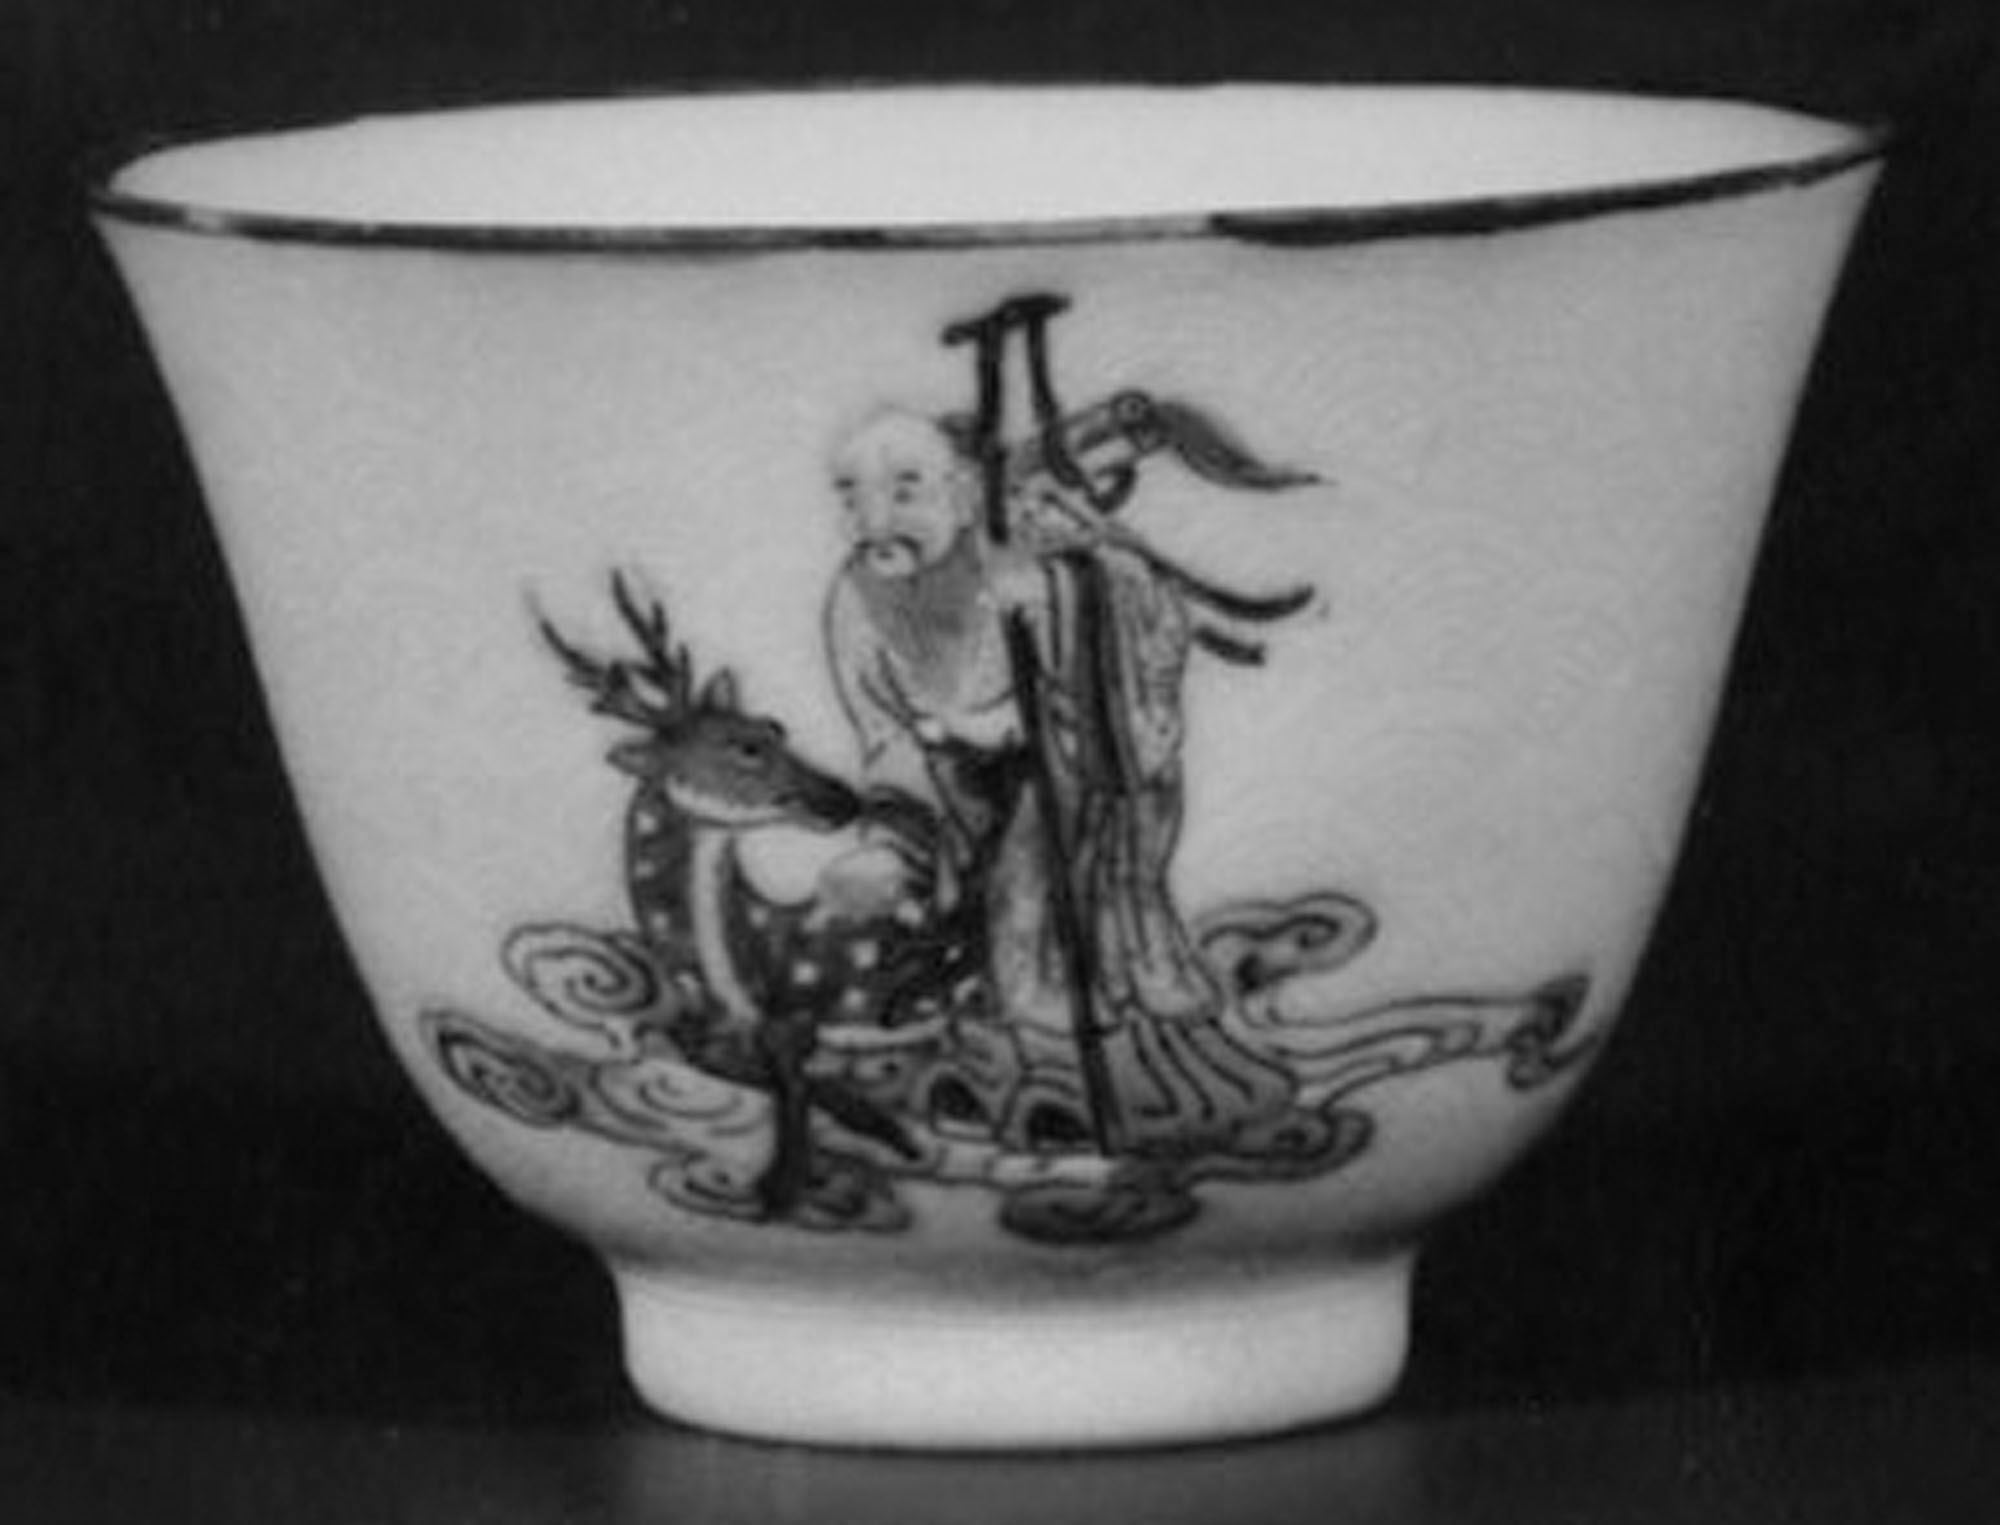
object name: cup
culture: chinese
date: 1821-1850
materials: enamel, porcelain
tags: men,deer